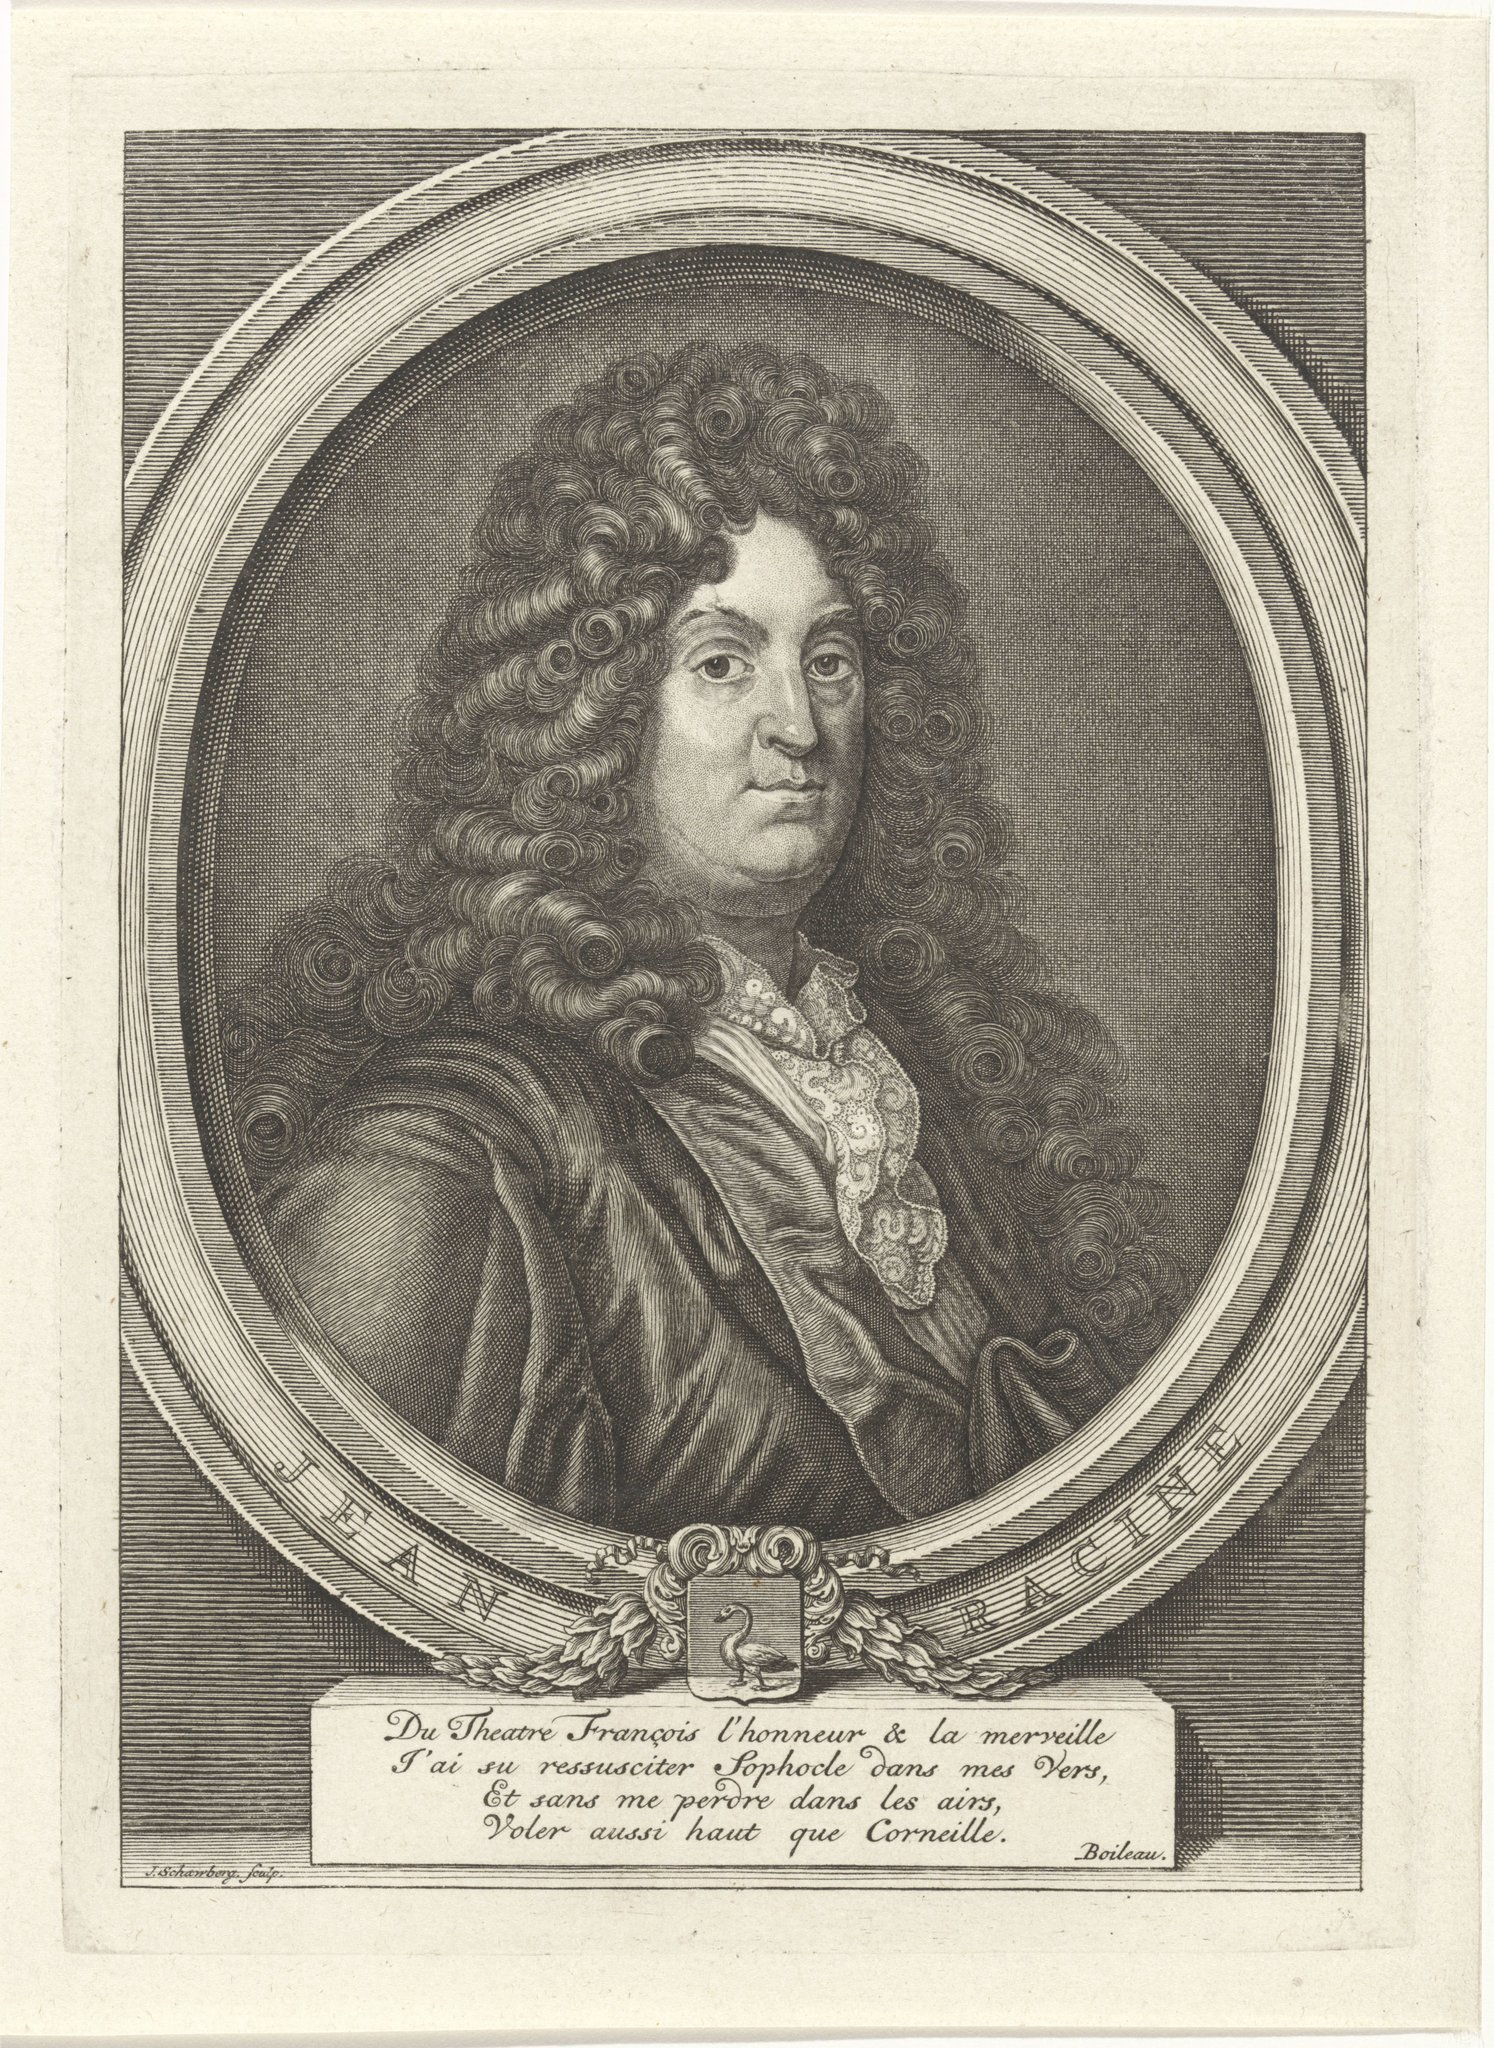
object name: print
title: Portret van Jean Racine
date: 1740-1760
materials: paper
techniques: engraving, etching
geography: antwerp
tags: france, paris, jean racine, water-birds: swan, portrait of a writer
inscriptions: collector's mark: Lugt 2228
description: Buste naar rechts van de Franse toneelschrijver Jean Racine in een ovale omlijsting. Daaronder een wapen met een zwaan en een vierregelig, Frans puntdicht van Boileau.